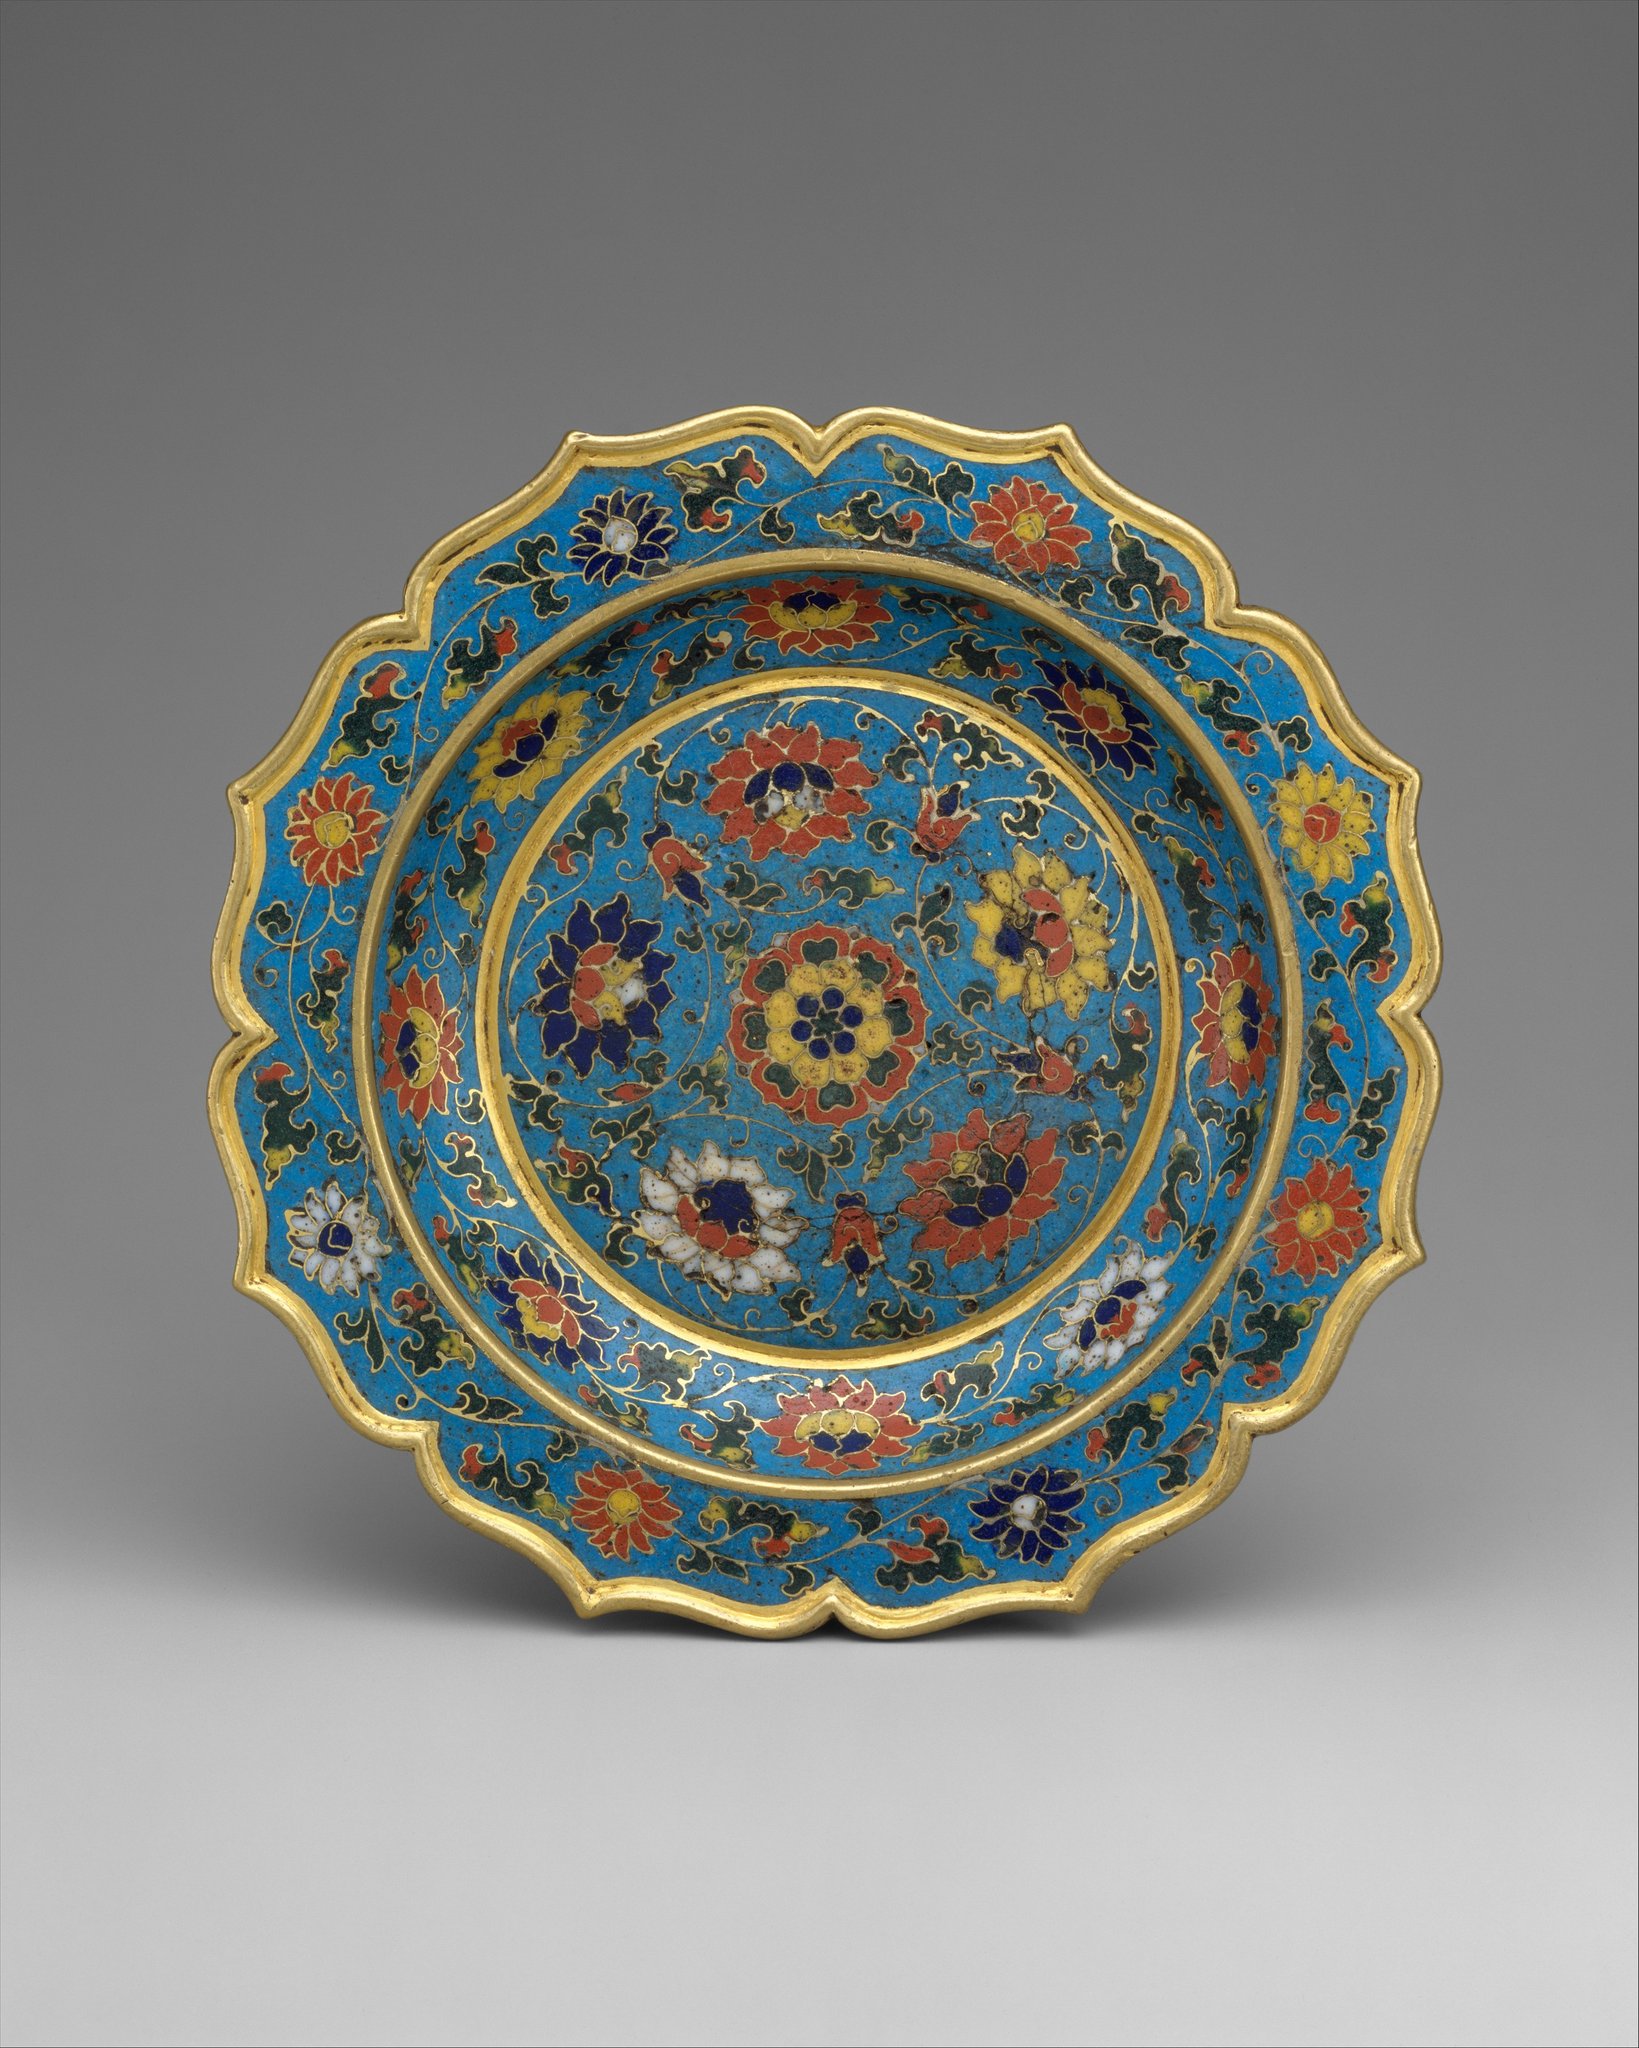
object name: dish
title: Foliated dish with floral scrolls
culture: chinese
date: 1401-1433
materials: enamel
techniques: enamel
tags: flowers